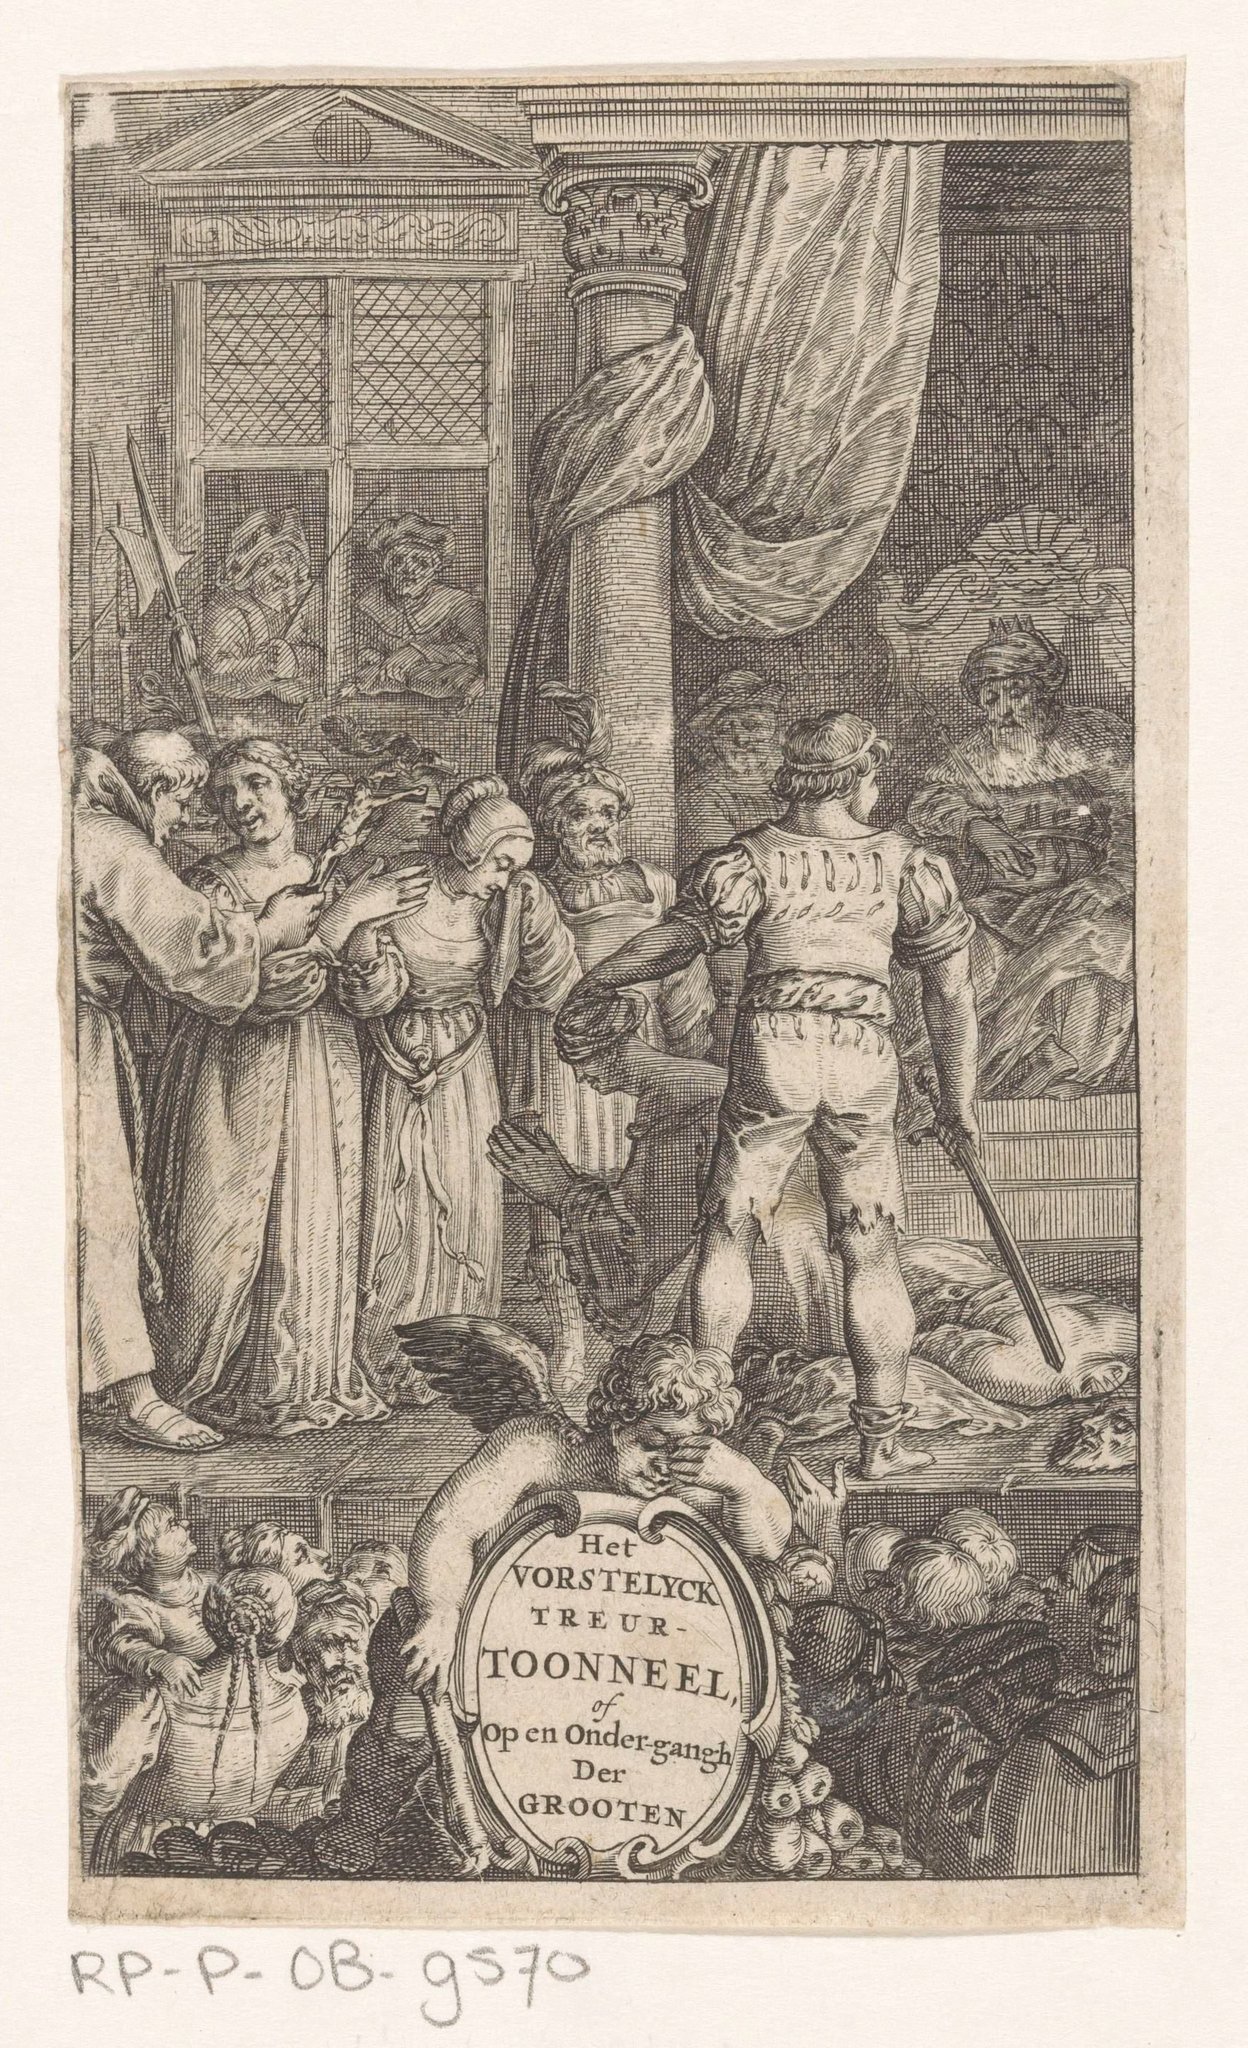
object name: print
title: Onthoofding van Anna Boleyn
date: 1652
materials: paper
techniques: engraving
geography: amsterdam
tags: london, kneeling figure - aa - female human figure, queen, empress, etc. (wife of a ruler), violent death by beheading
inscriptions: collector's mark: Lugt 2228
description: Een vrouw, mogelijk Anna Boleyn, zit met een doek op het hoofd geknield voor een beul met zwaard die op het punt staat haar te onthoofden. Naast hen ligt een onthoofde man, mogelijk de broer of één van de andere zogenaamde minnaars van de koningin. Rechts zit een gekroonde man, mogelijk Hendrik VIII, op een troon. Links en in de voorgrond staan toeschouwers onder wie een monnik met een kruisbeeld.